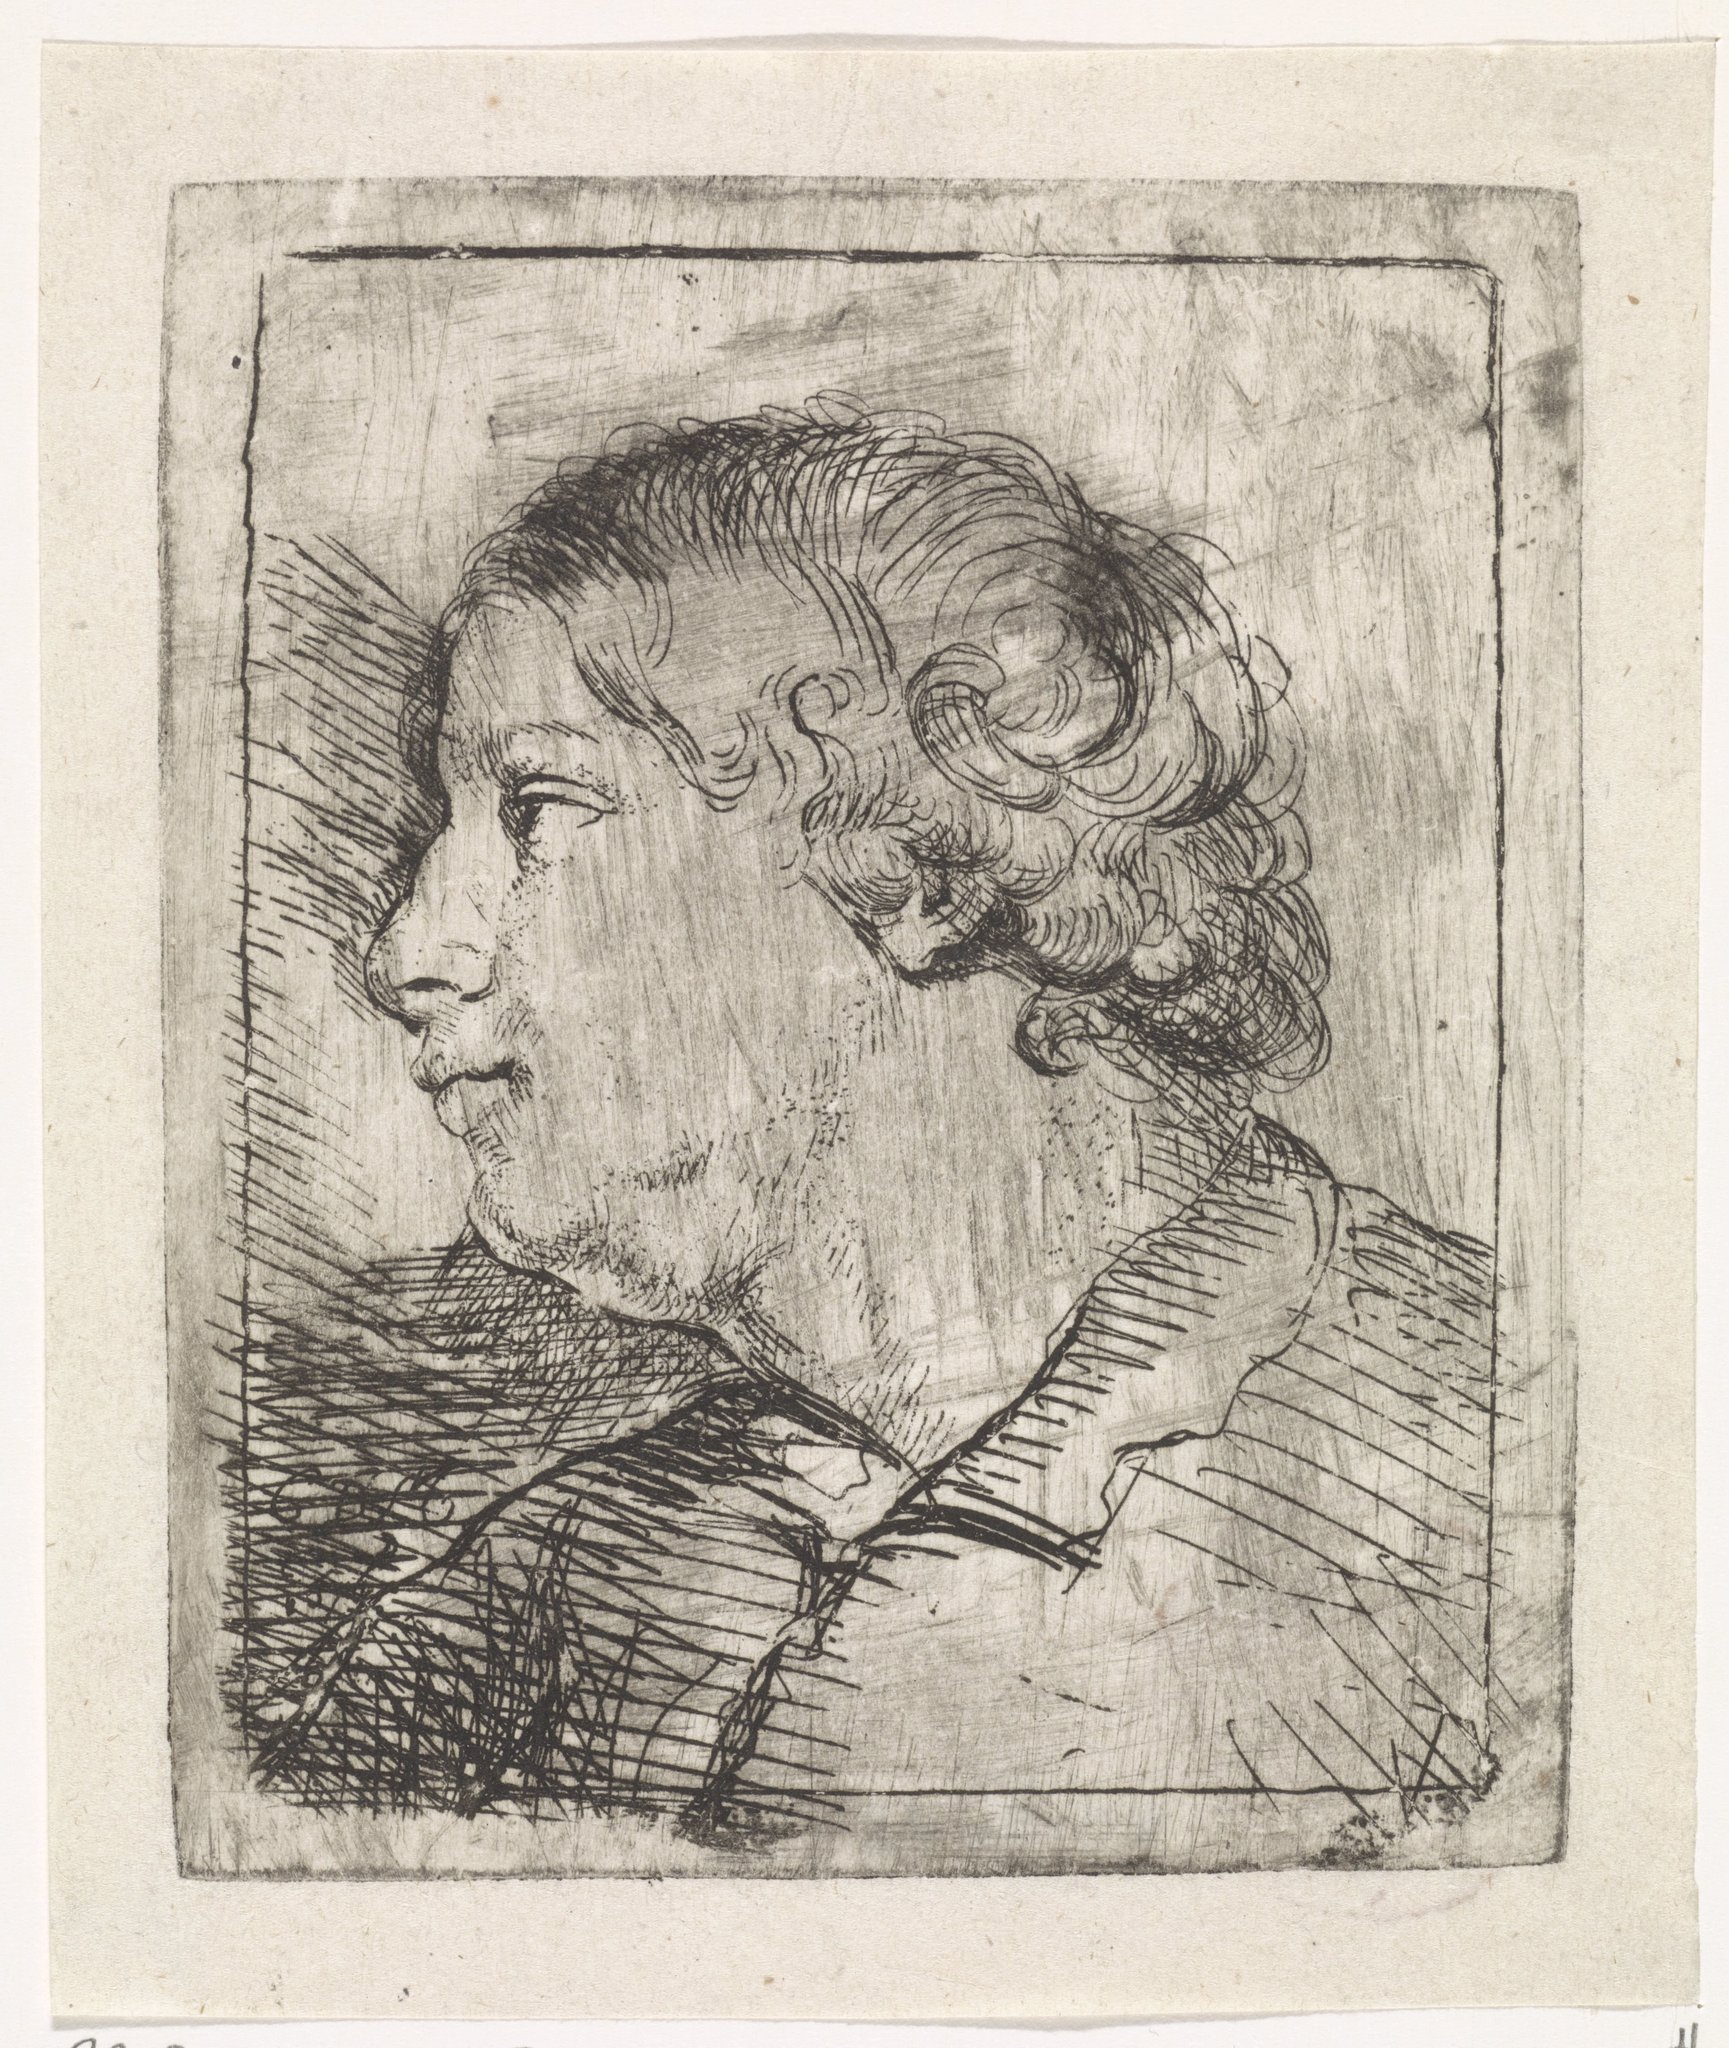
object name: print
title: Jongeman met een platte kraag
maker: carel de moor (ii)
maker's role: draughtsman, painter, print maker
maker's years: 1655-1738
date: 1665-1738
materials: paper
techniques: drypoint, etching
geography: netherlands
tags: youth, adolescent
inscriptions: collector's mark: Lugt 240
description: Een jongen met krullend haar en een platte kraag.